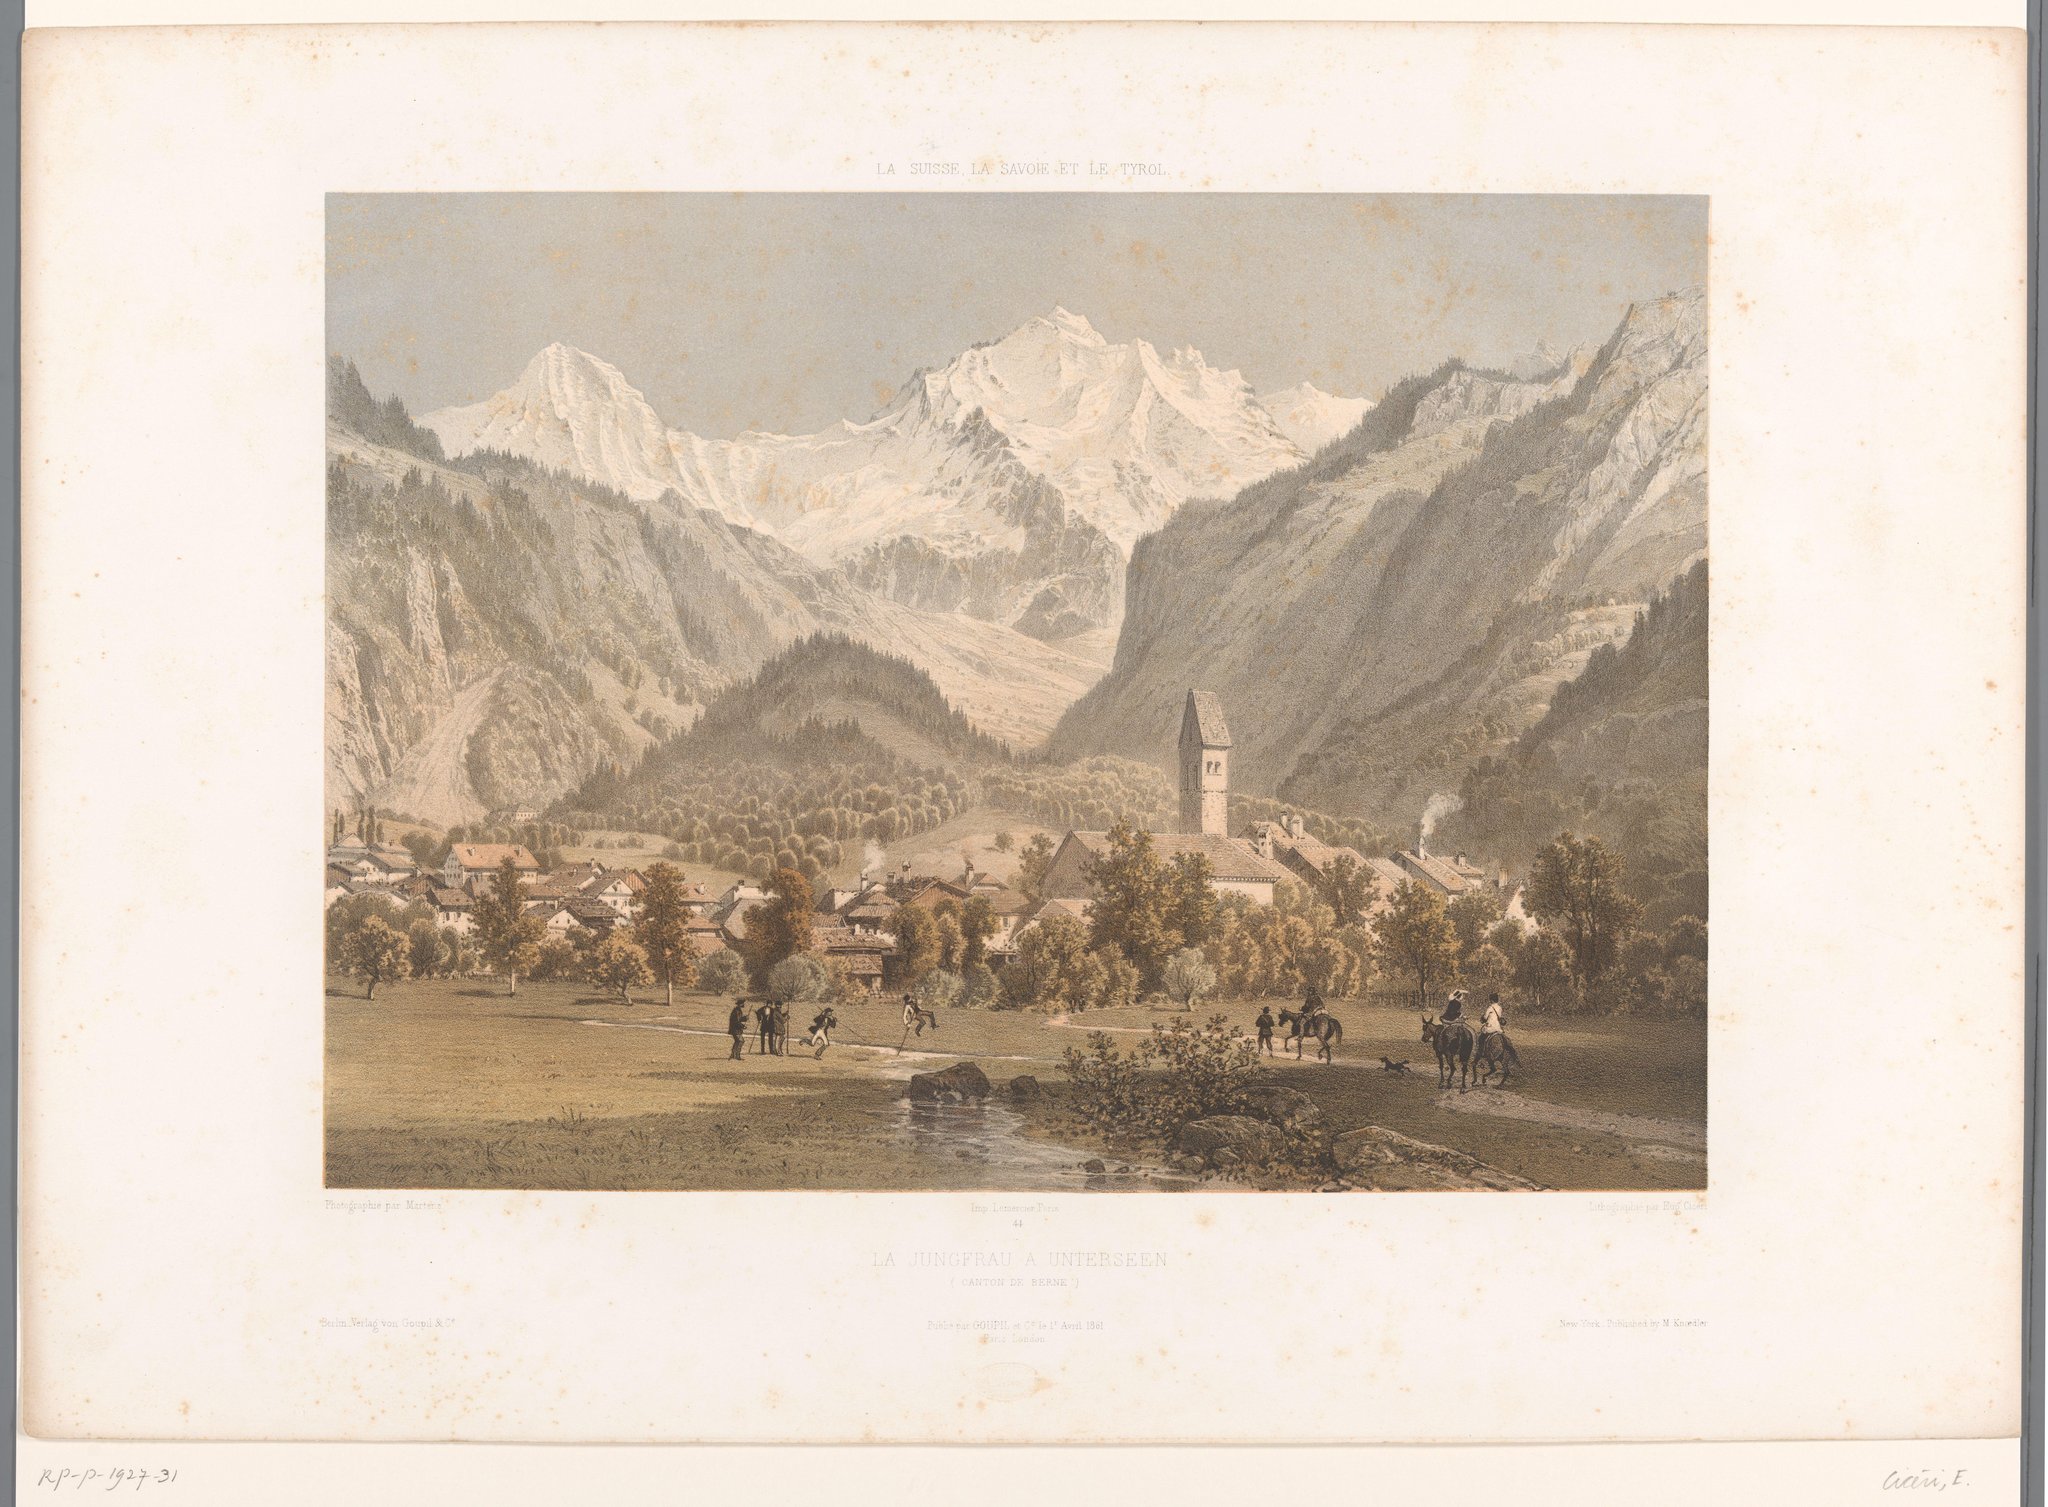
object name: print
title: La Suisse, la Savoie et le Tyrol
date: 1859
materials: paper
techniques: lithograph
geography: london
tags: mountain-range, snow peaks (+ landscape with figures, staffage), prospect of village, silhouette of village (+ city(-scape) with figures, staffage)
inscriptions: check stamp: Lugt 1090